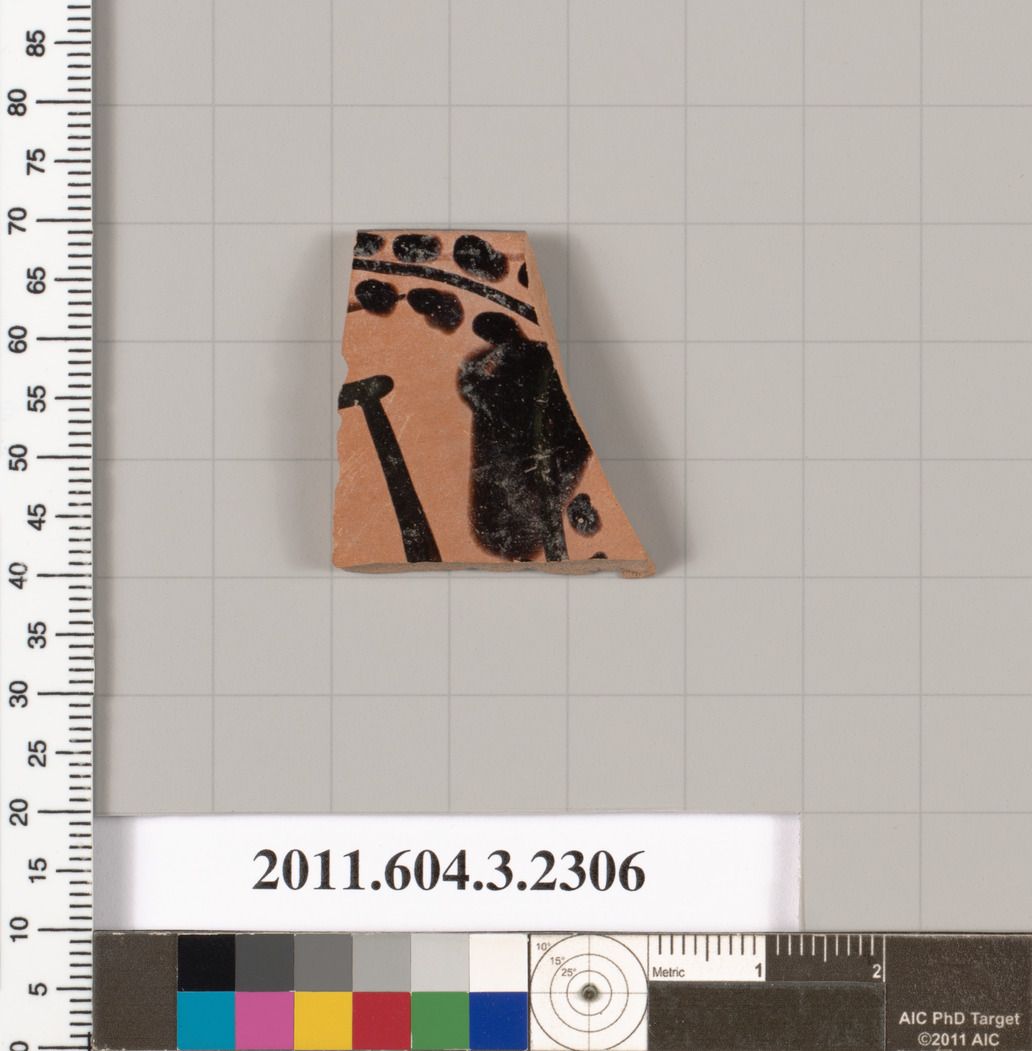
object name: kylix fragment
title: Terracotta rim fragment of a kylix: eye-cup (drinking cup)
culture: greek, attic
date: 530-500 BCE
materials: terracotta